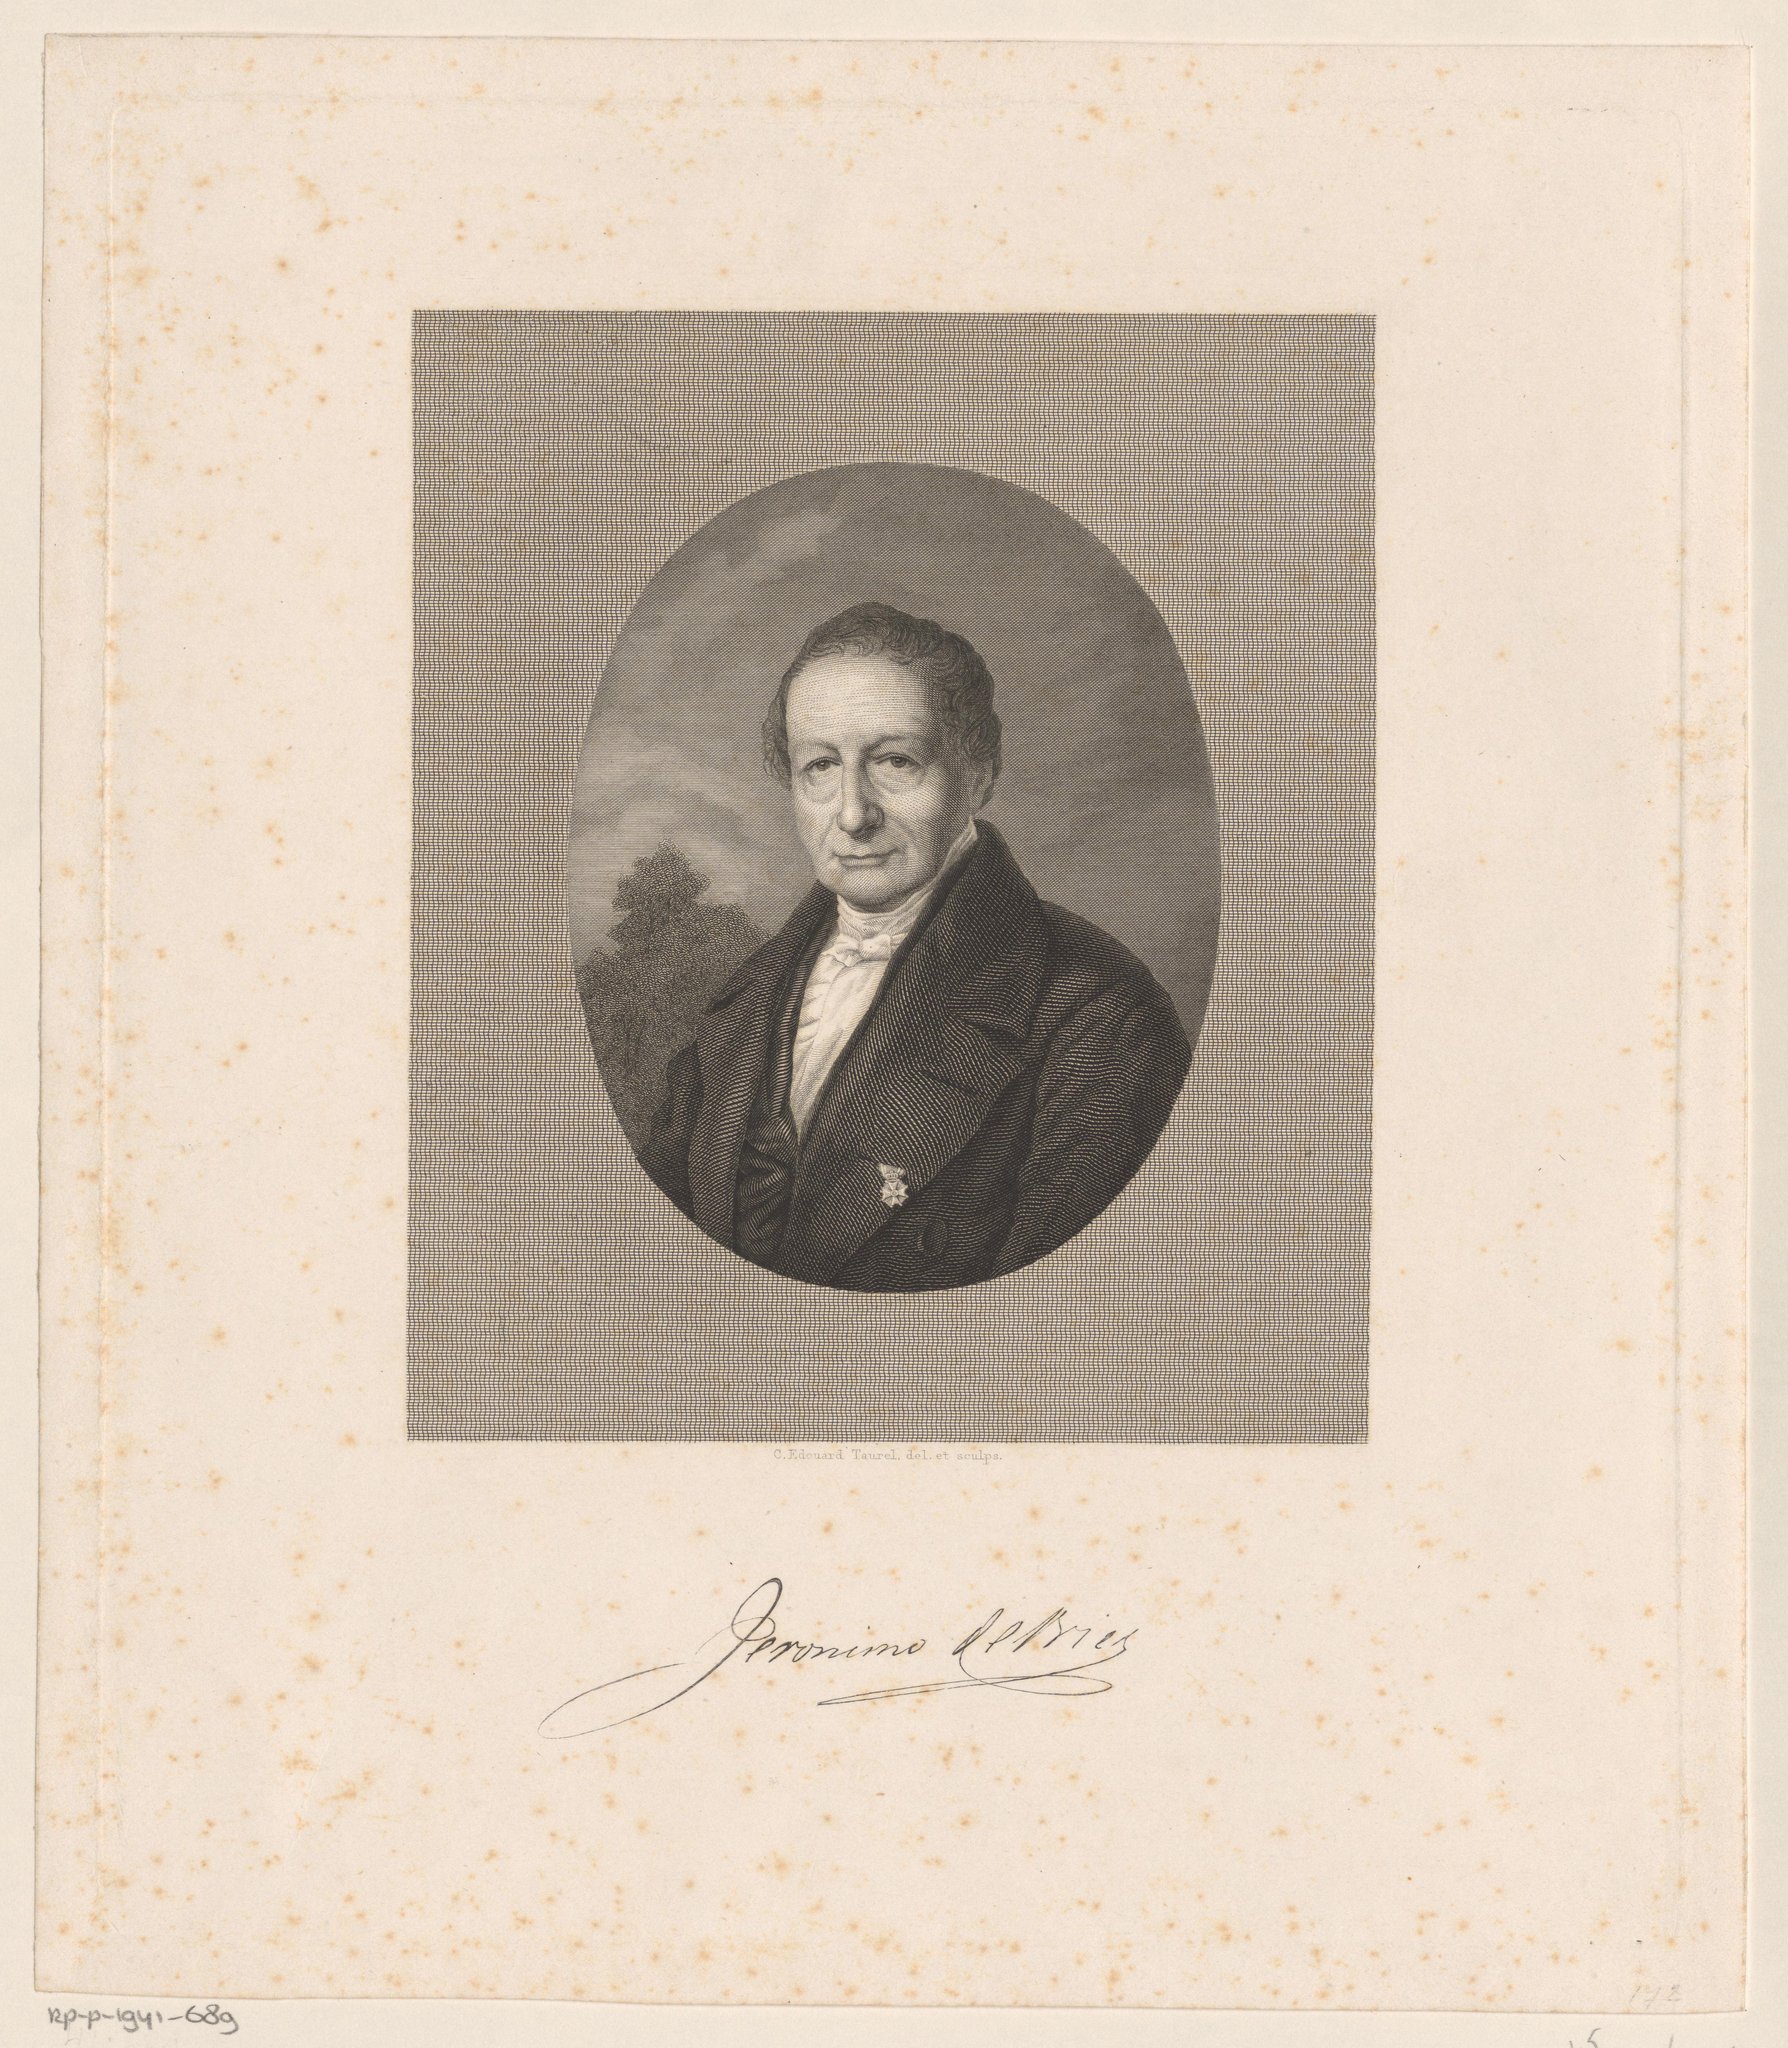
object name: print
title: Portret van Jeronimo de Vries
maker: edouard taurel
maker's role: draughtsman, print maker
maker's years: 1824-1892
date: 1834-1892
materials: paper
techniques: engraving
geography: amsterdam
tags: amsterdam, jeronimo de vries, official; civil servant; functionary (in general), historical persons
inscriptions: collector's mark: Lugt 2228